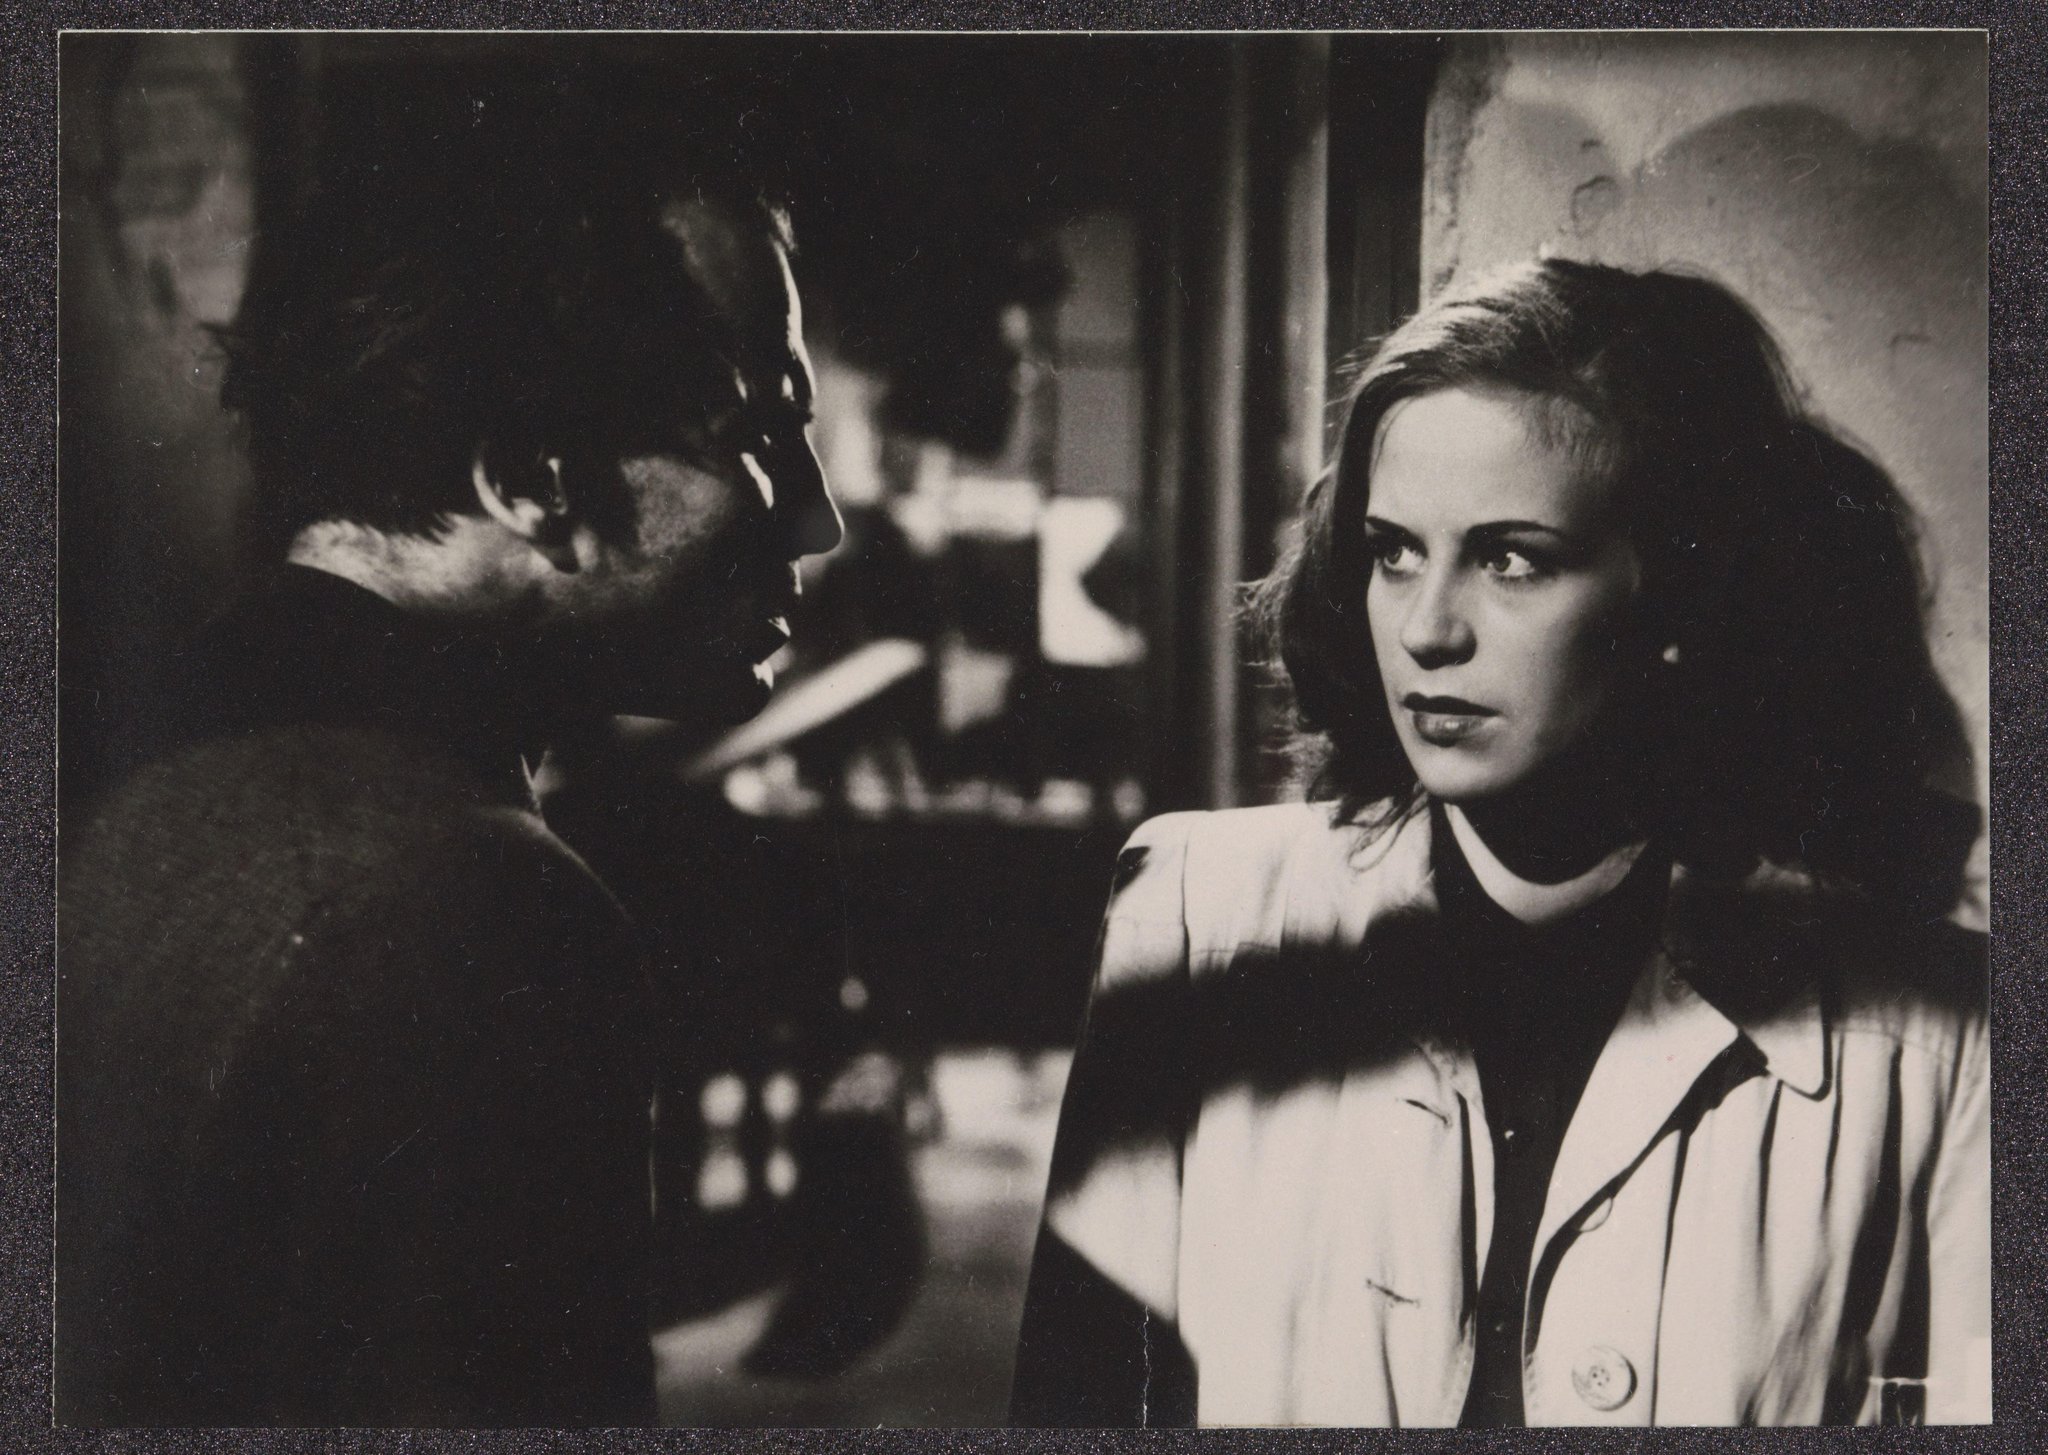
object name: photograph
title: Die Mörder sind unter uns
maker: Anonymous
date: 1946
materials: paper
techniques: gelatin silver print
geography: berlin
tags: film actor (on the screen), berlin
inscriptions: stamp: ‘Nederlands Filmmuseum/ Amsterdam’, inscription: ‘Die Mörder sind unter uns/ 1946/ Wolfgang Staudte’, inscription: ‘Knef/ Borchert’